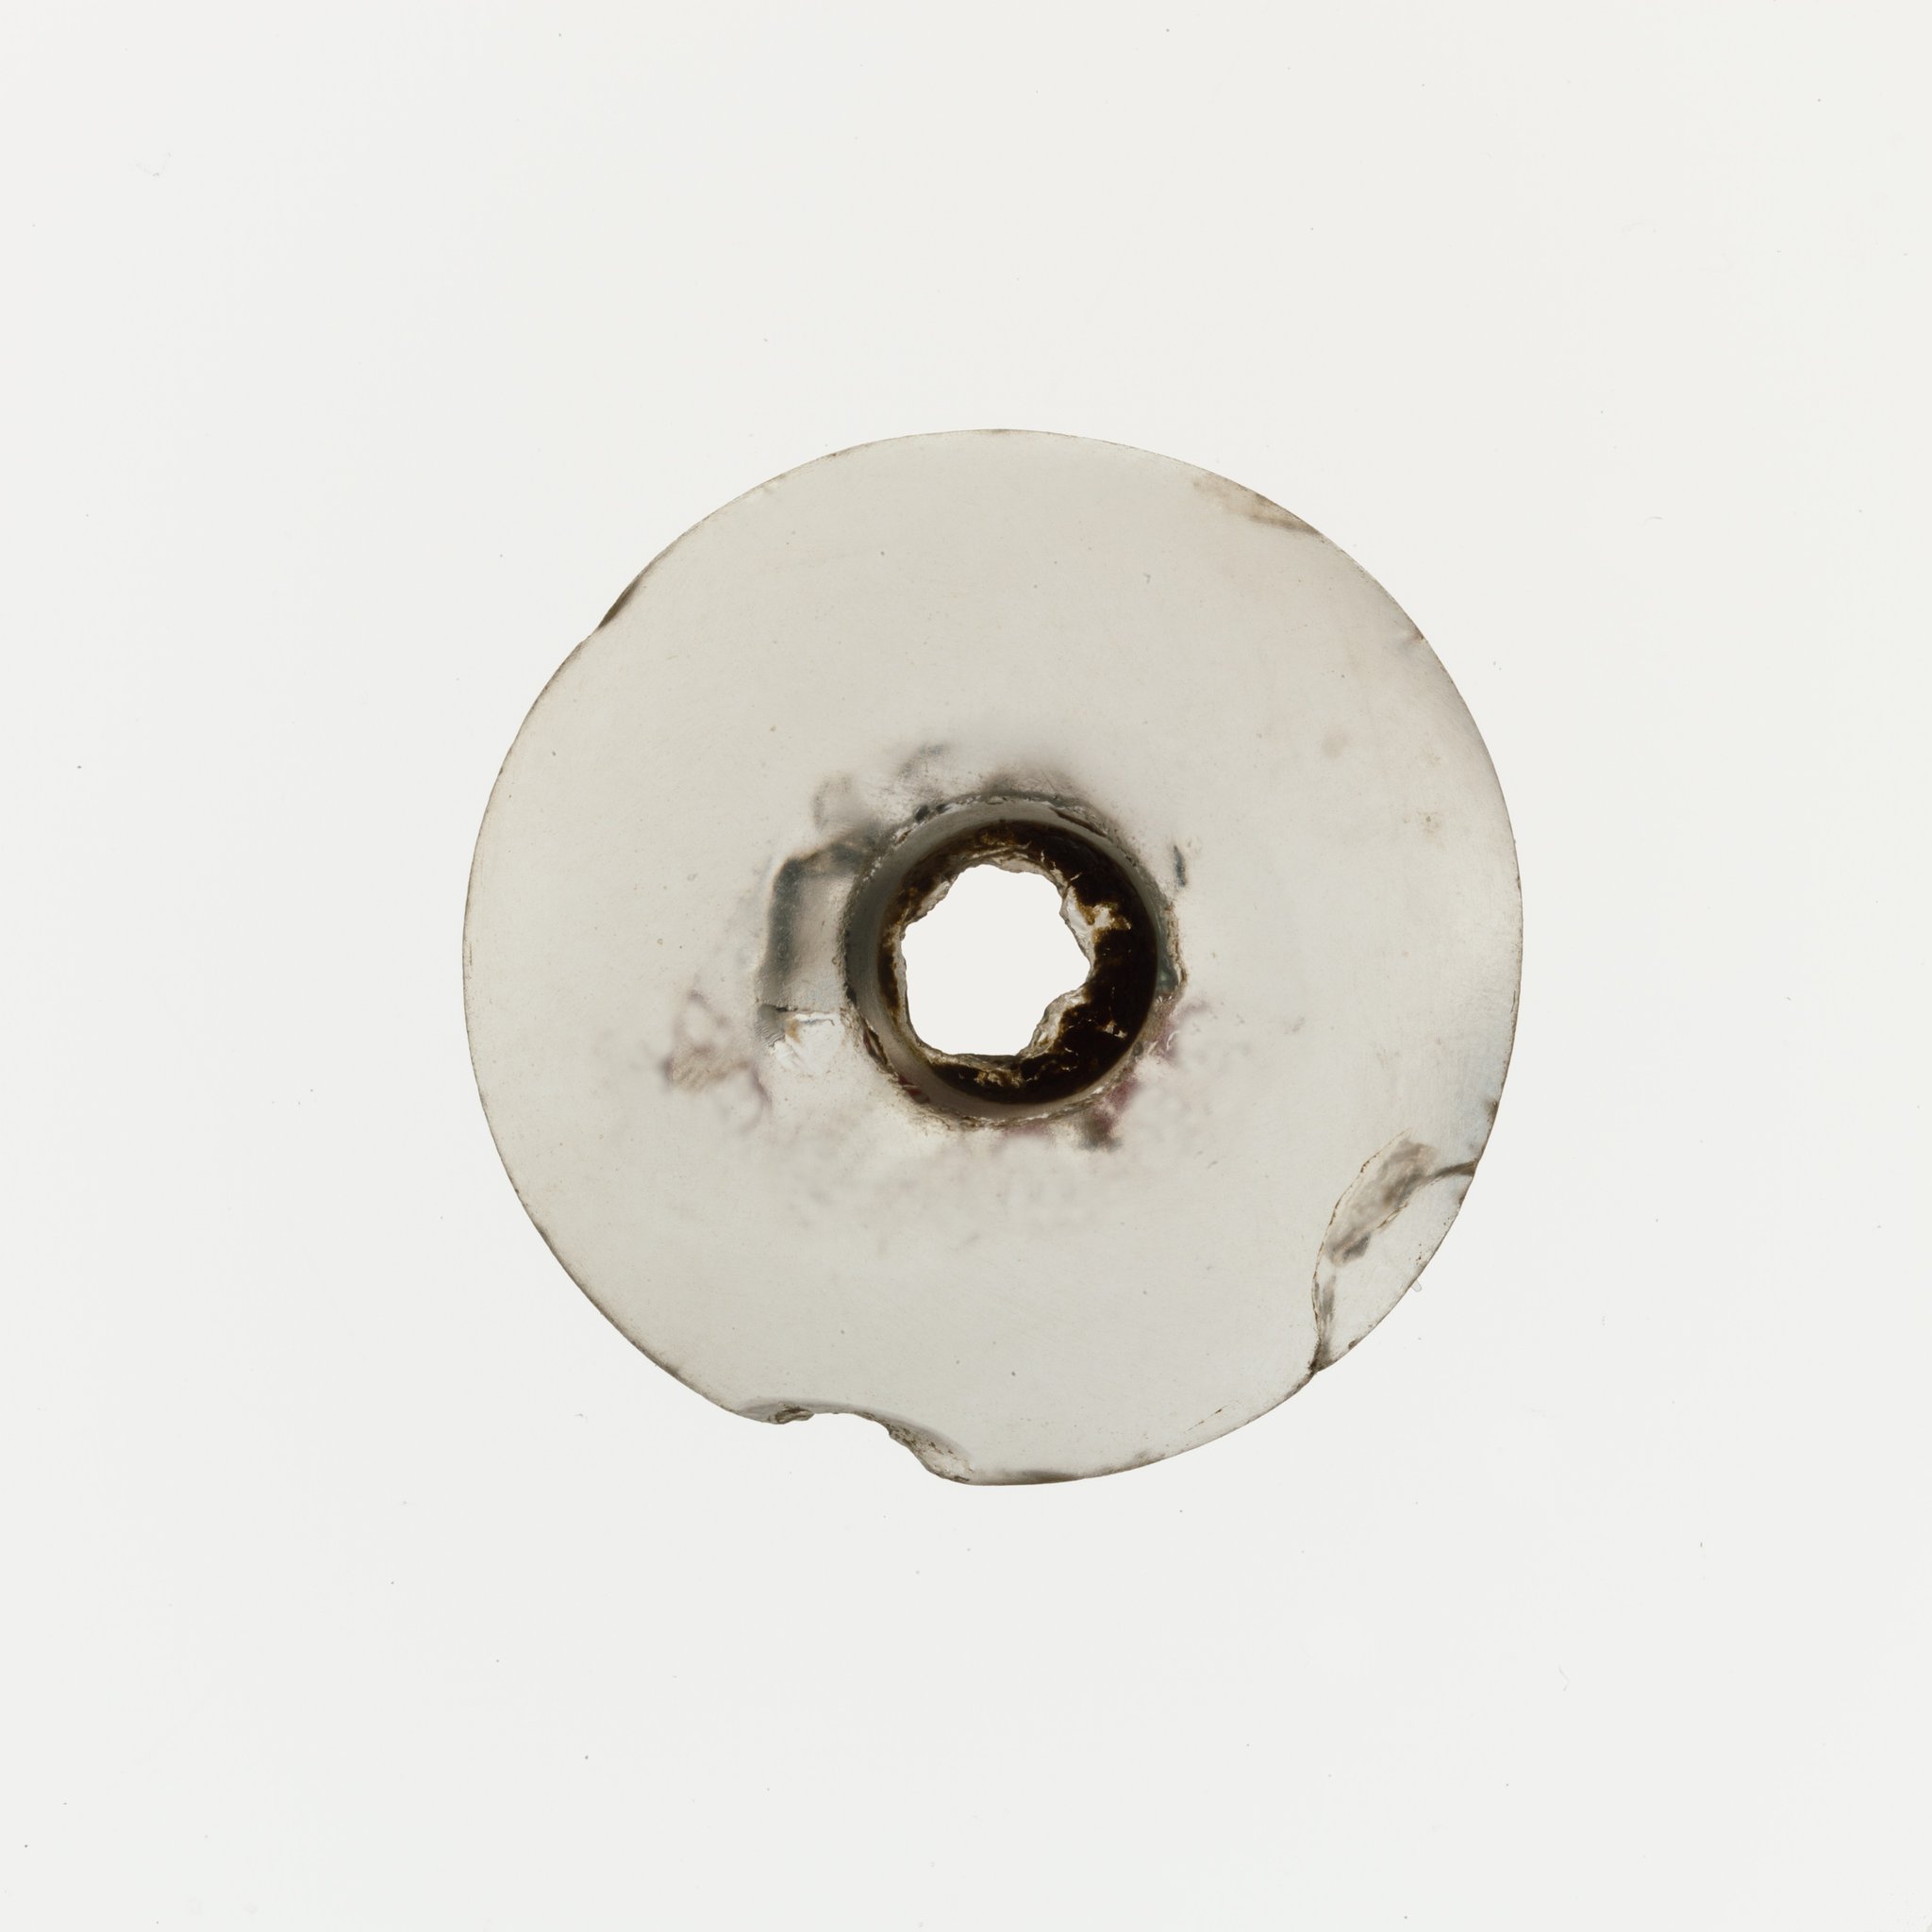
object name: spindle whorl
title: Rock crystal spindle whorl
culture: minoan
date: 2200-1450 BCE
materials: quartz